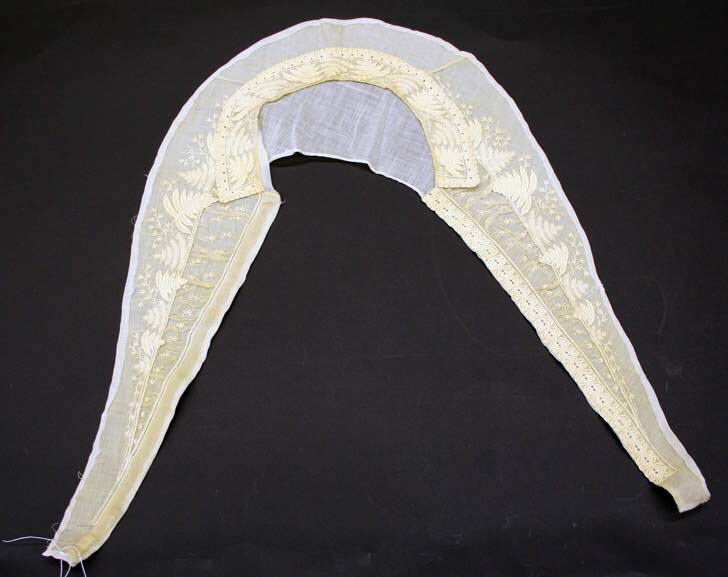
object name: vestee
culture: american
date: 1855-1869